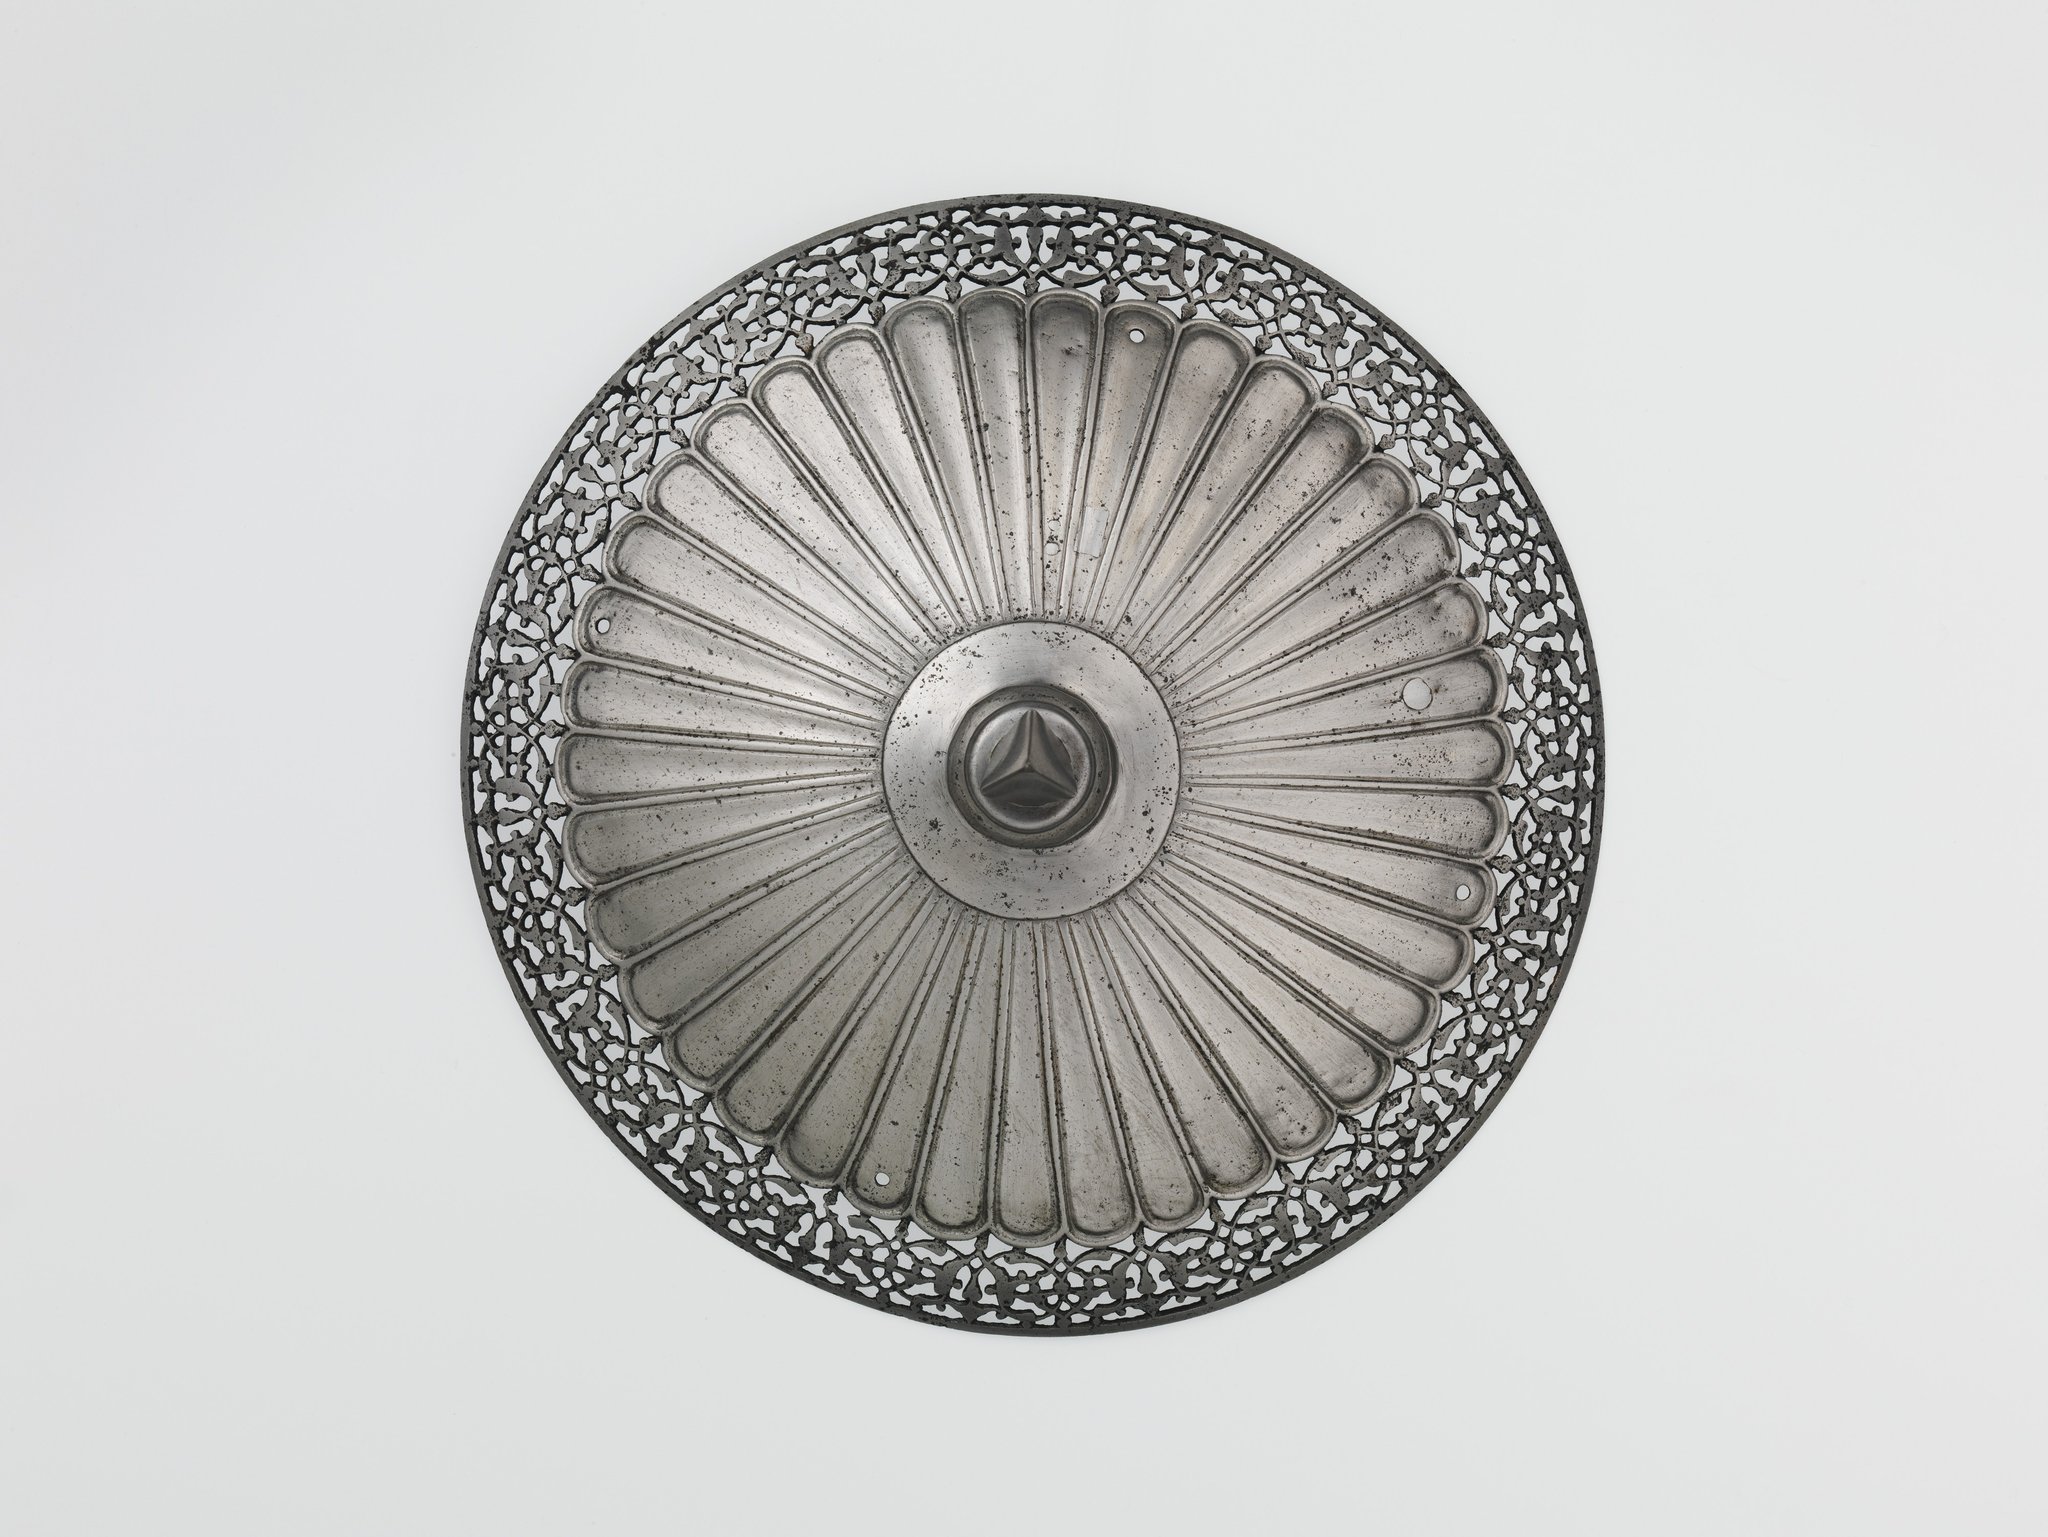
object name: shield bos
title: Shield Boss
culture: turkish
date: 1501-1700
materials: steel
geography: ottoman empire